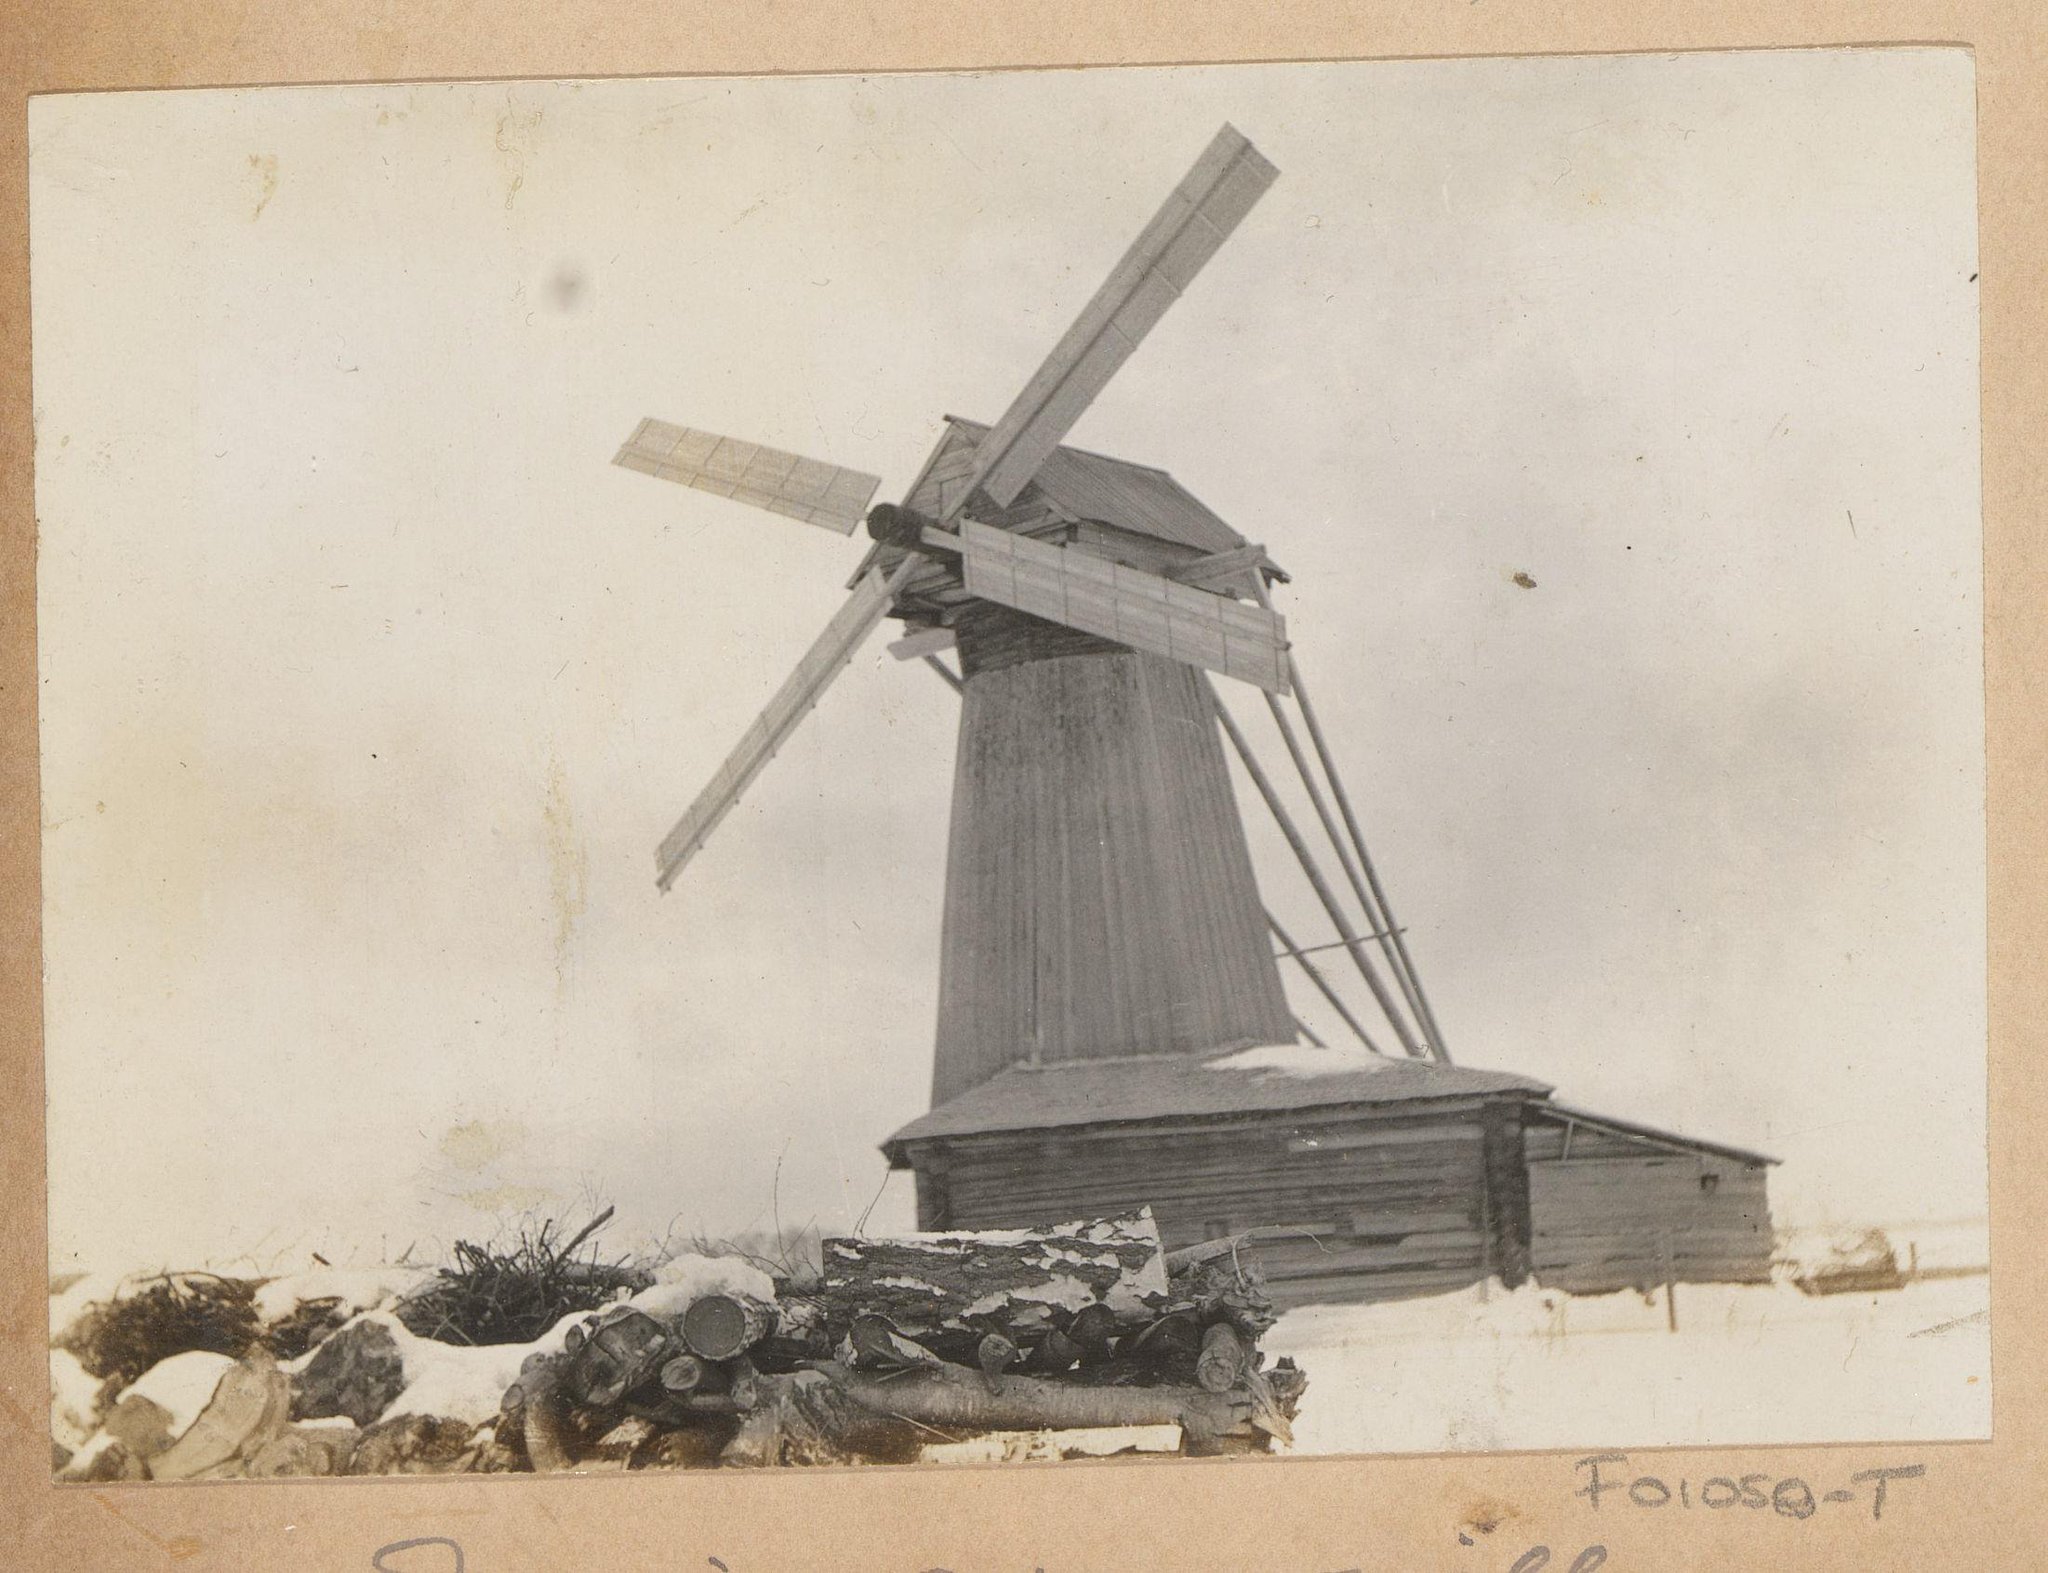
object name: photograph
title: Houten korenmolen in Rusland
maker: joseph cheetham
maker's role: engineer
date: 1903-1904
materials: photographic support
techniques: gelatin silver print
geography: russia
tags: windmill in landscape, russia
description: Onderdeel van Fotoalbum van de Engelse familie Cheetham met opnames van hun verblijf in Rusland.